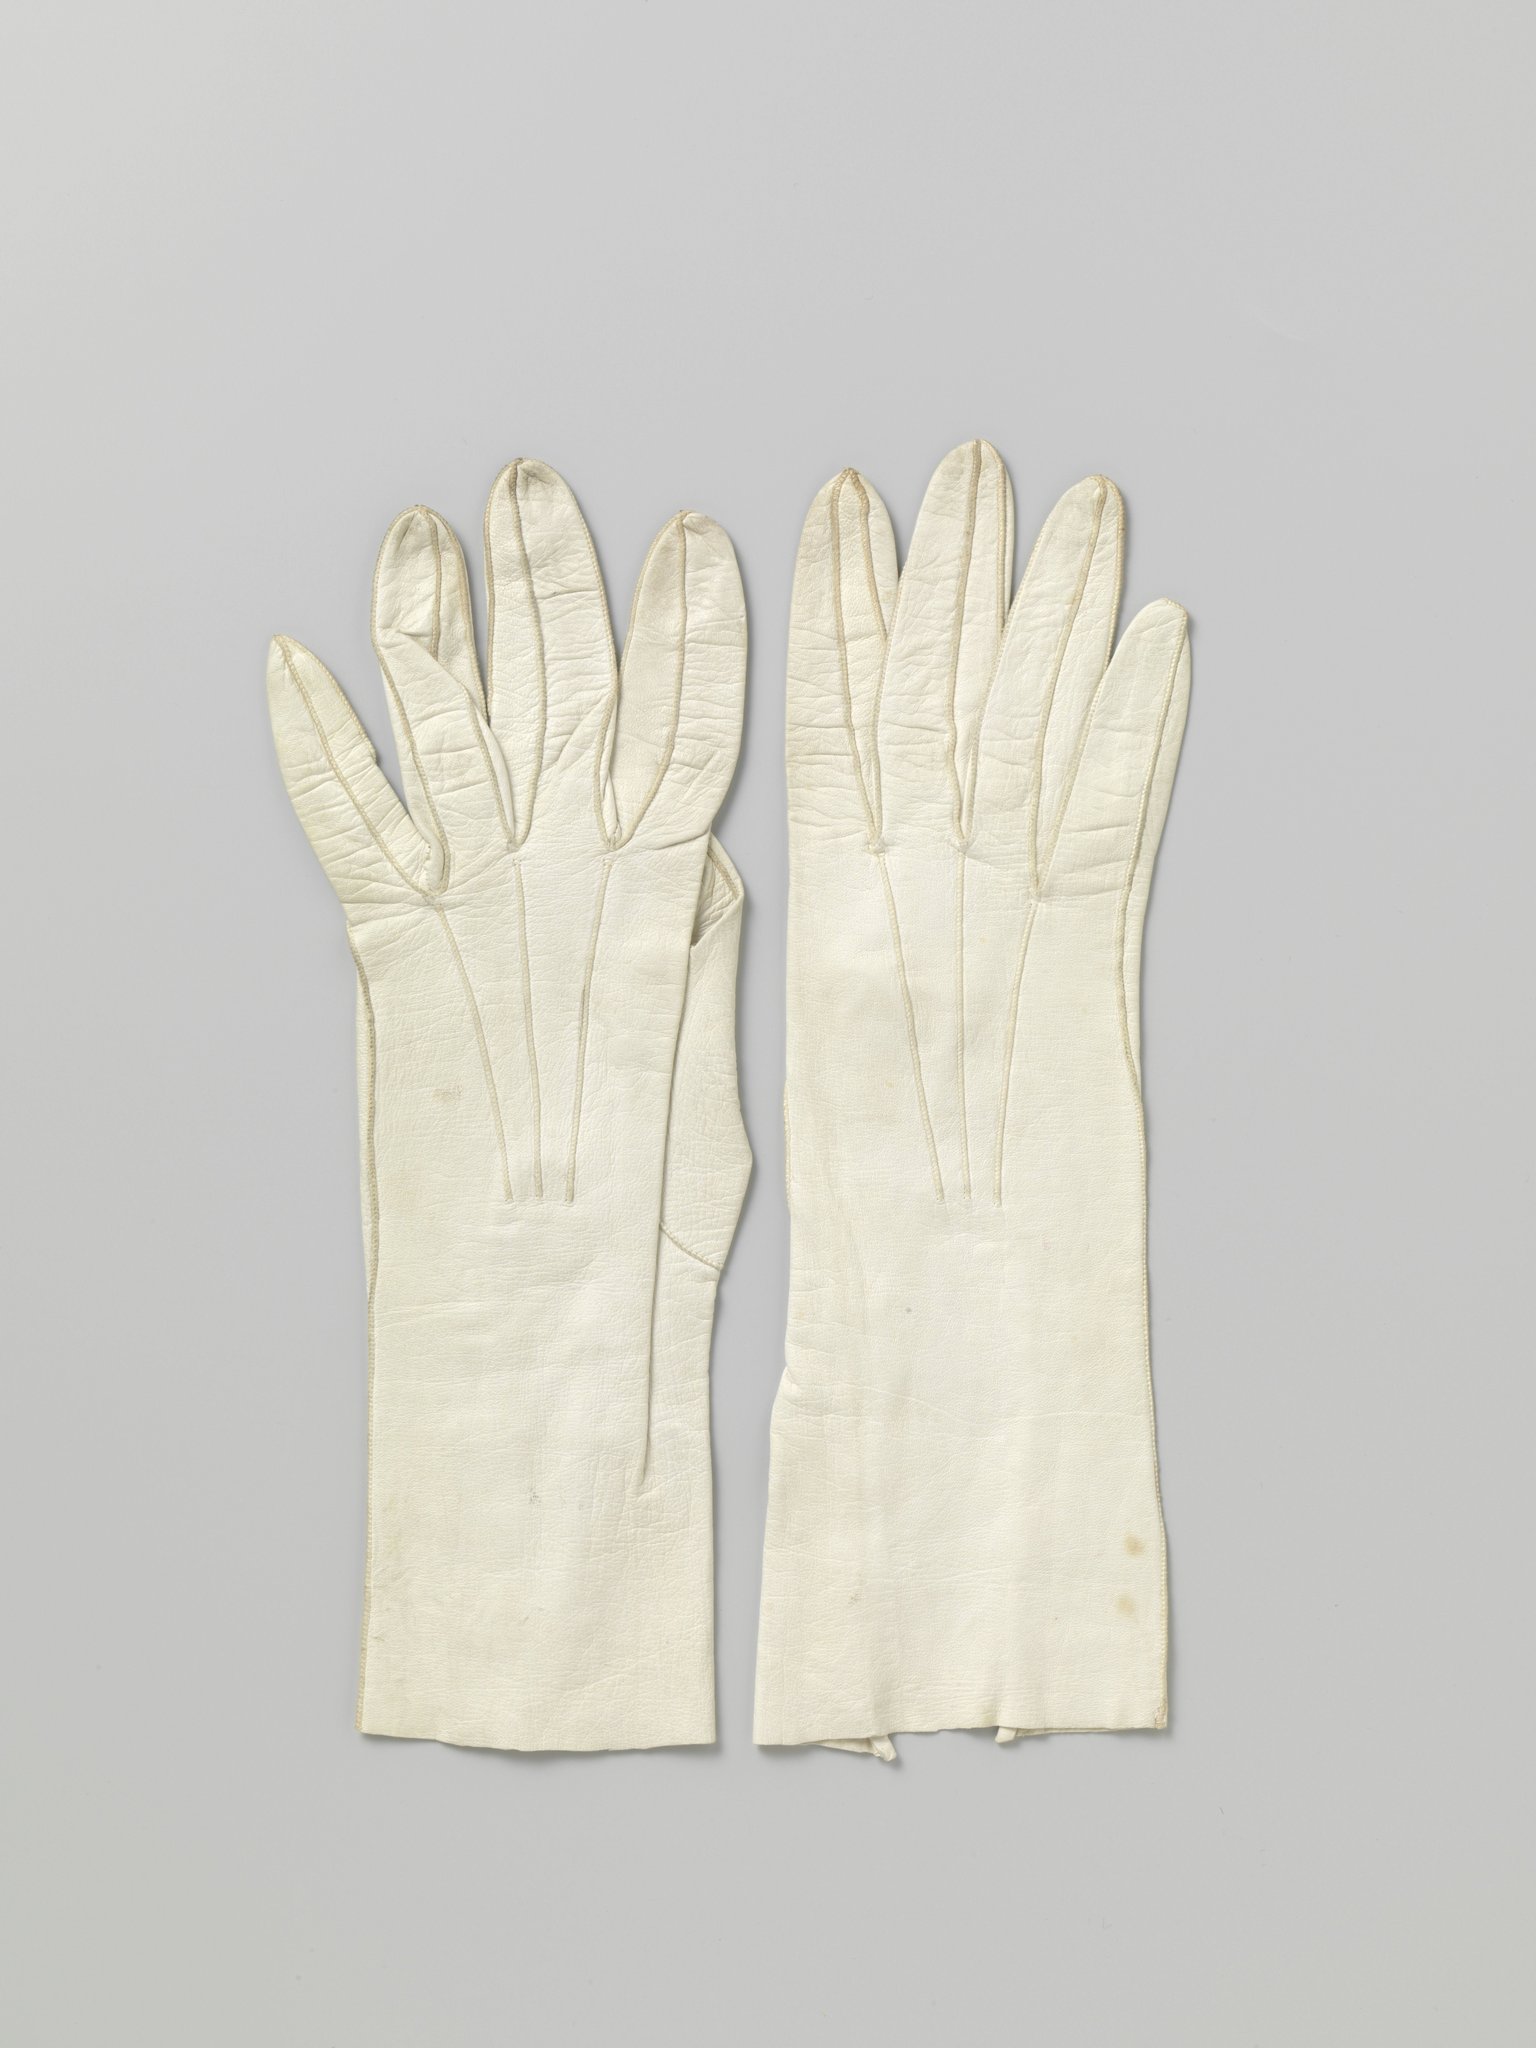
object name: glove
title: Handschoen van wit kalfsleer en sluiting met vier parelmoeren knopen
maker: Anonymous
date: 1900-1950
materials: leather, mother of pearl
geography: western europe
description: Linker handschoenen van wit kalfsleer en sluiting met vier parelmoeren knopen. Kort model, waarschijnlijk van oorsprong lang en later afgeknipt.